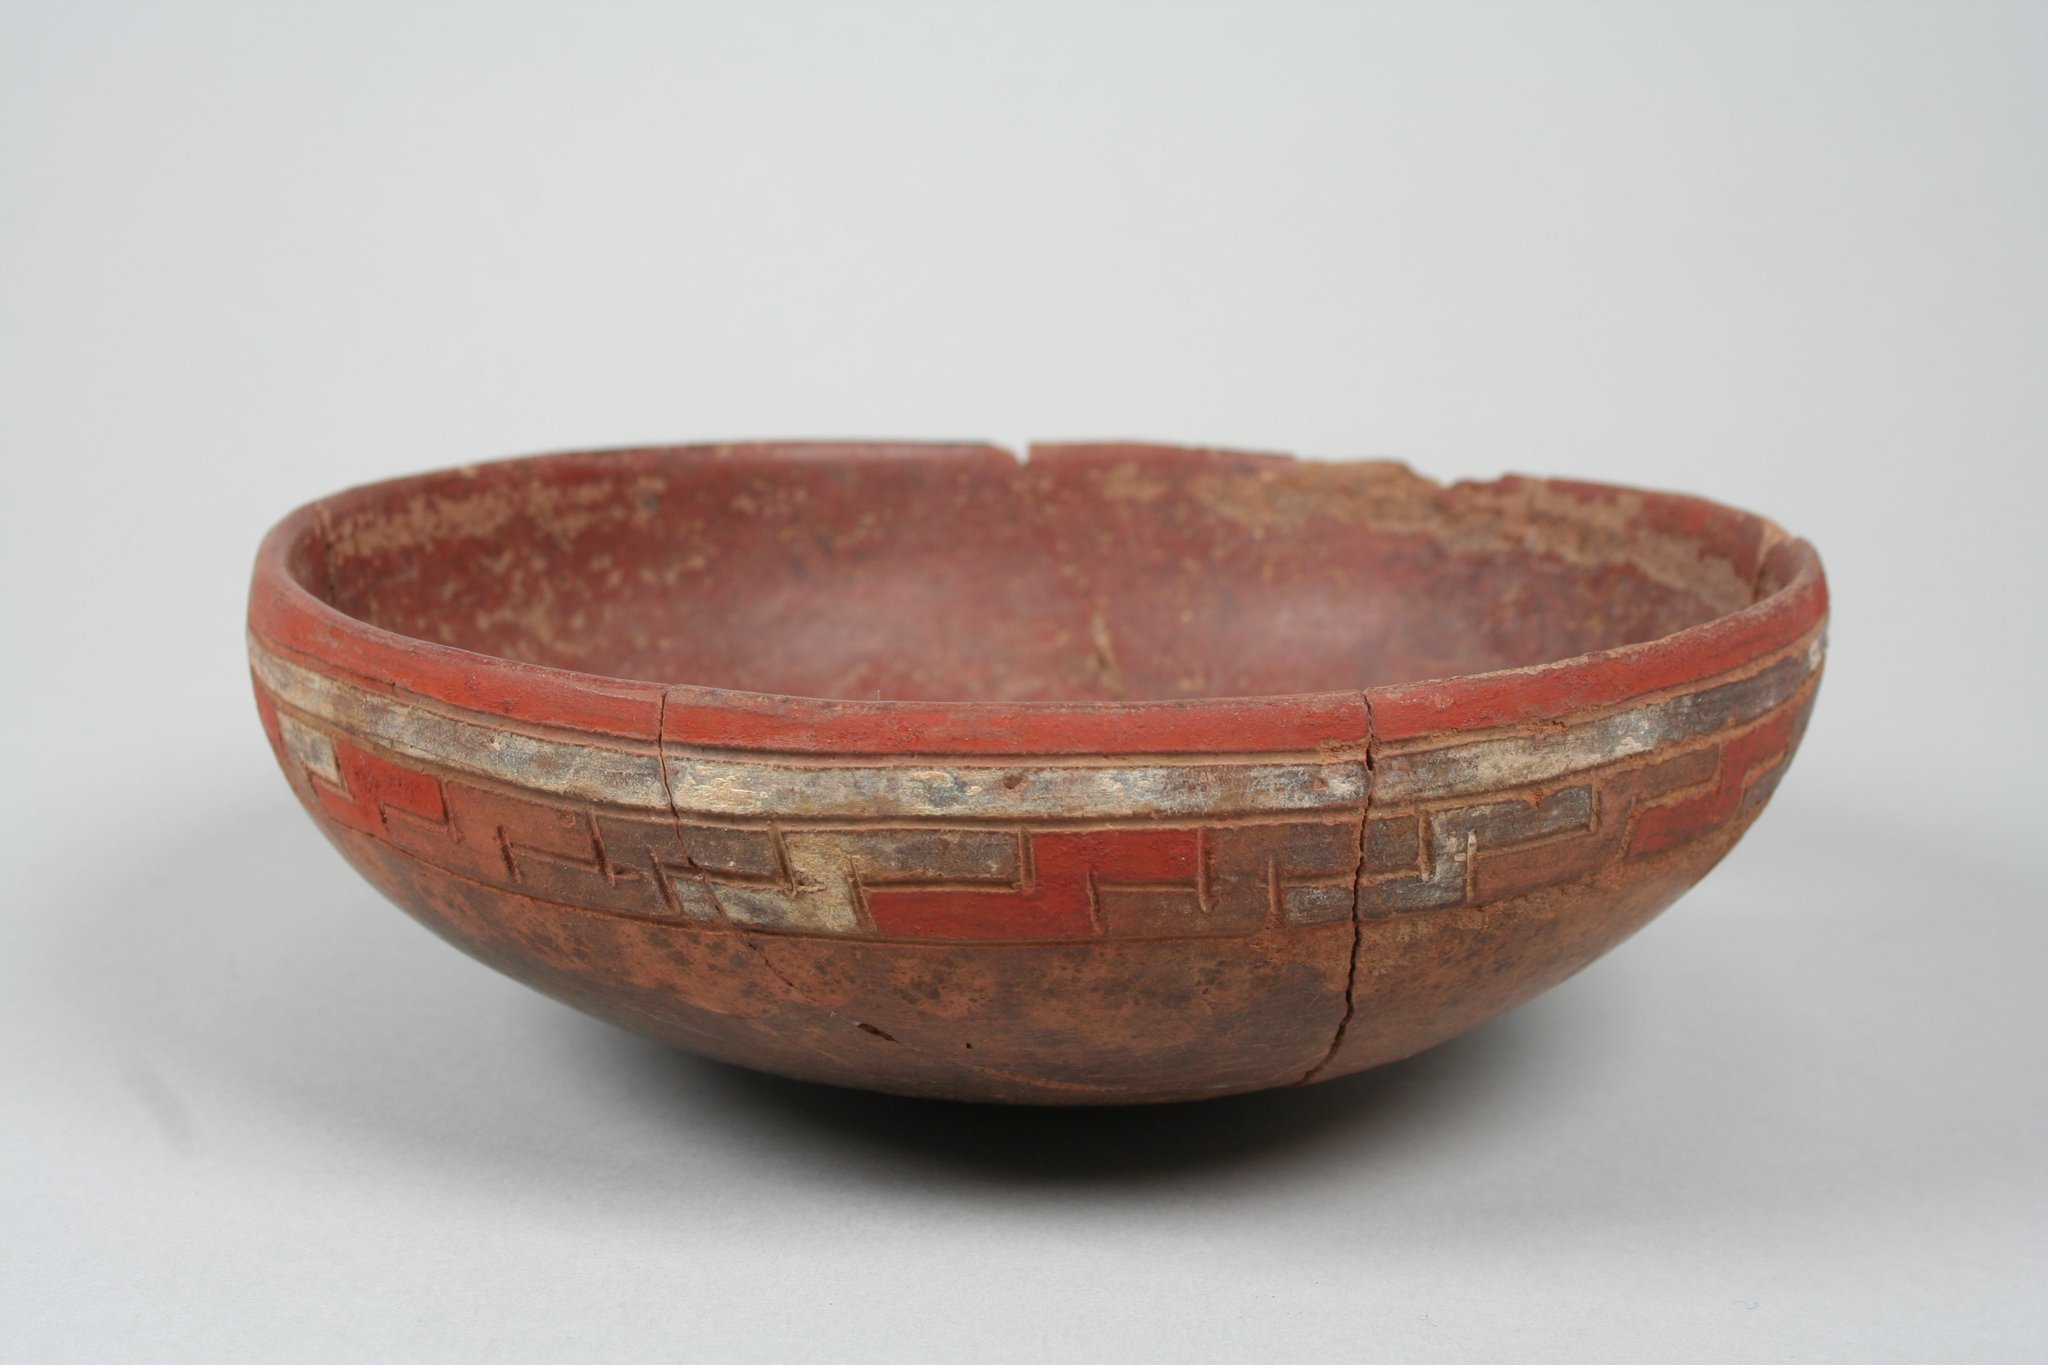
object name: bowl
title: Incised bowl with dots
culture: paracas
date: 700-401 BCE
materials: ceramic, pigment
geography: peru